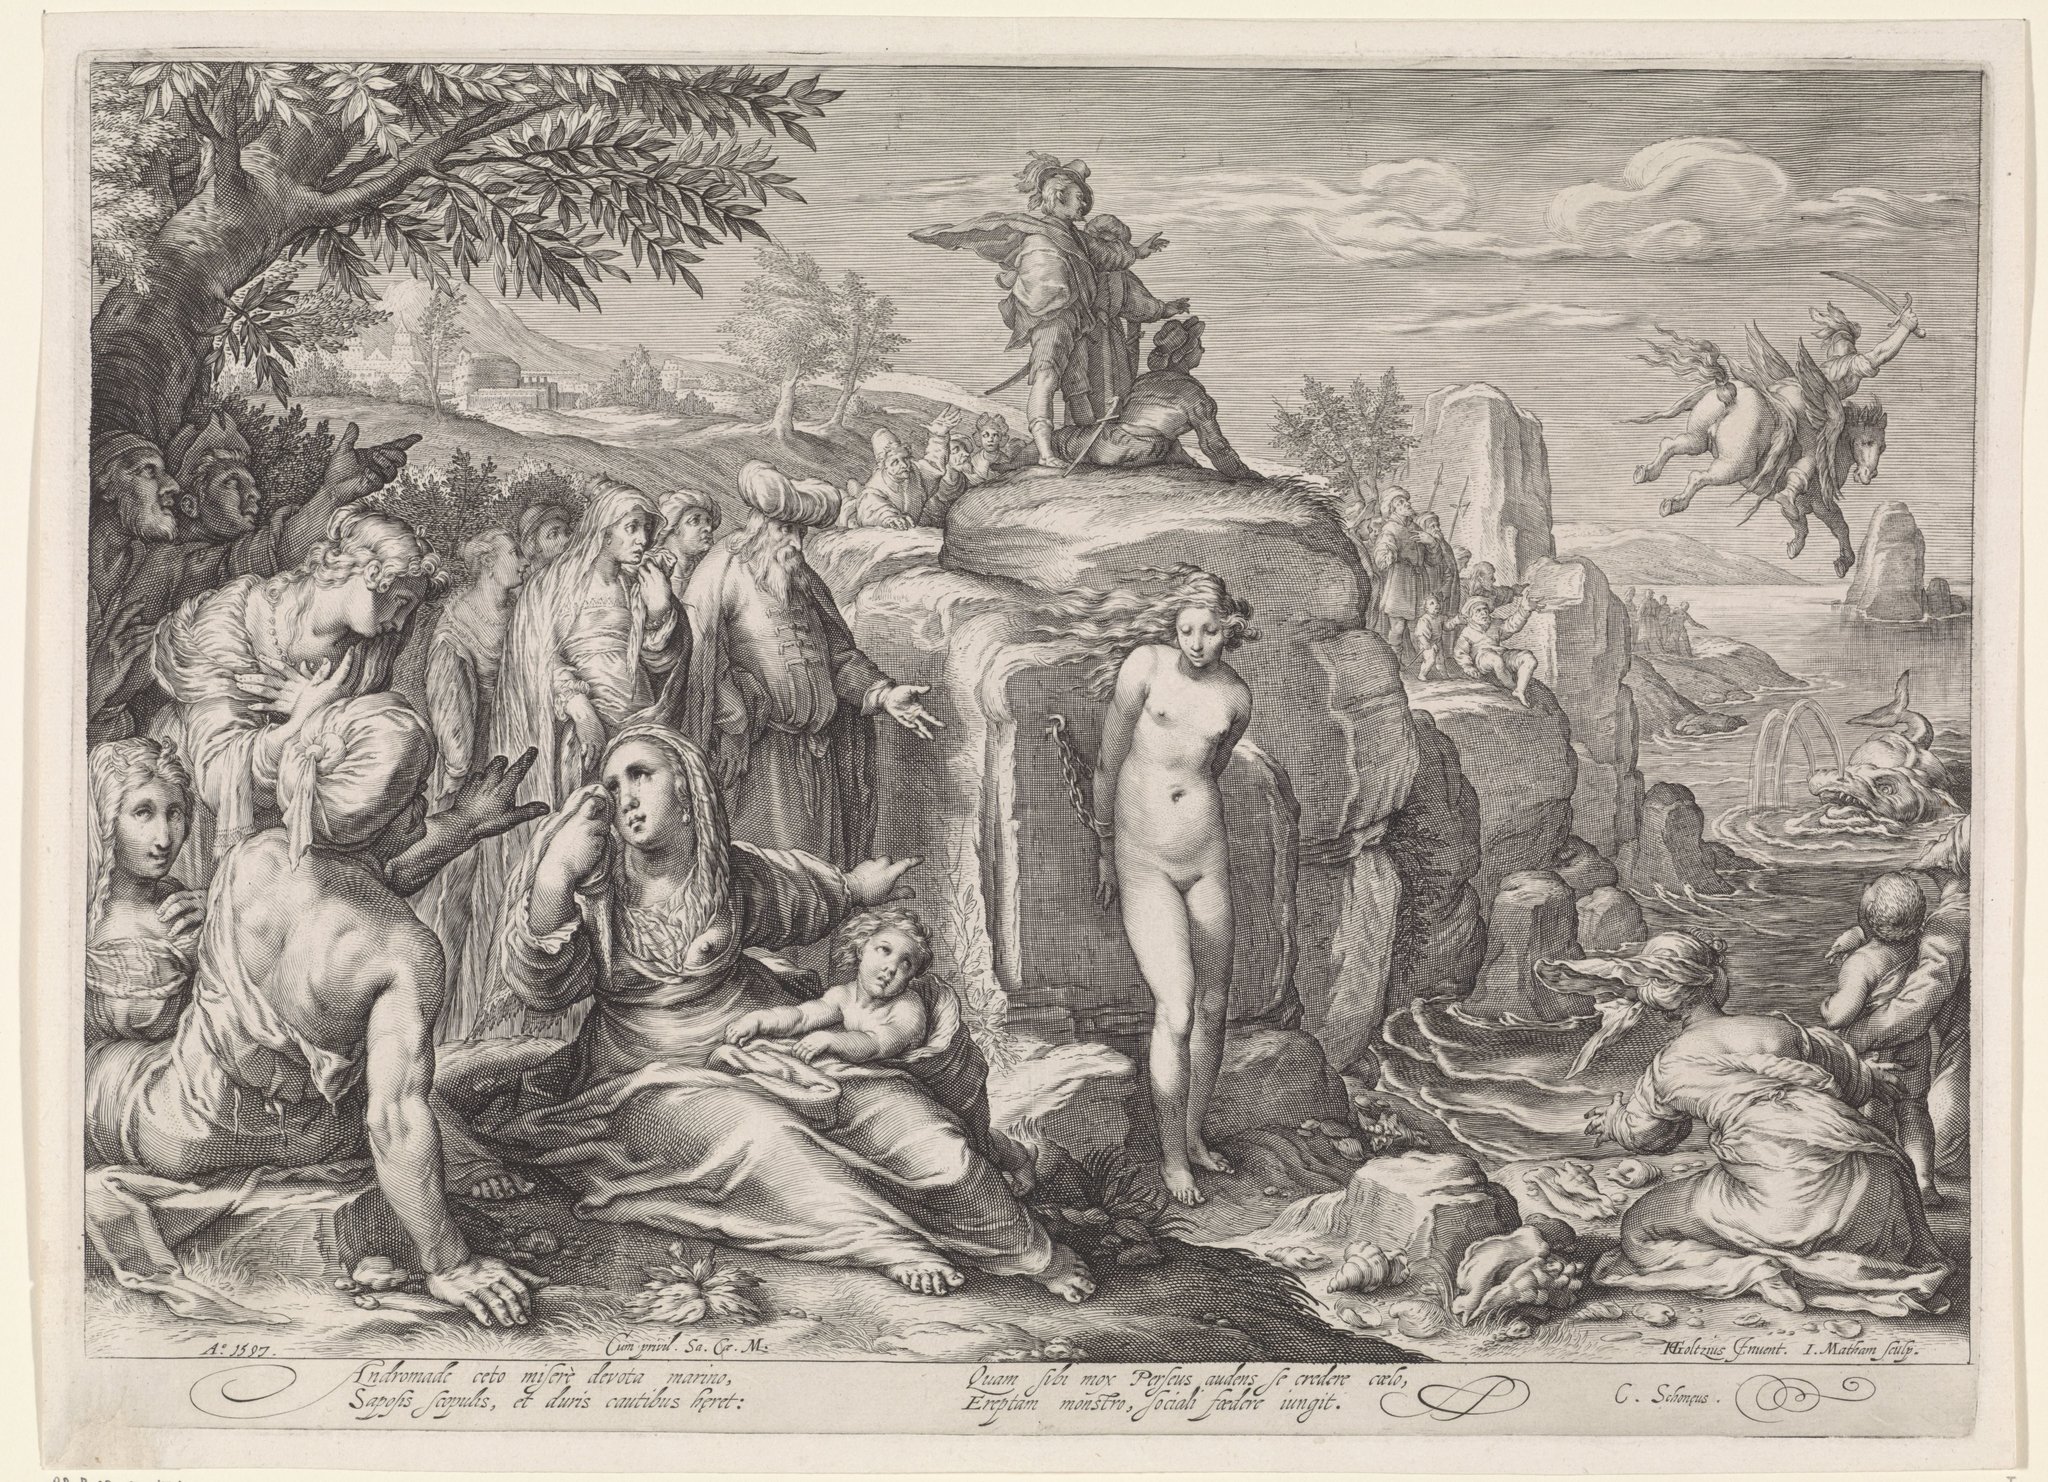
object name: print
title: Andromeda aan de rots geketend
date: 1597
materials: paper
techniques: engraving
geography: haarlem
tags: perseus and andromeda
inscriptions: collector's mark: Lugt 240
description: Andromeda is aan een rots geketend, als offer aan een zeemonster, dat rechts in het water ligt. Daarboven vliegt Perseus, klaar om het monster te doden. De ouders van Andromeda en omstanders treuren en wijzen.